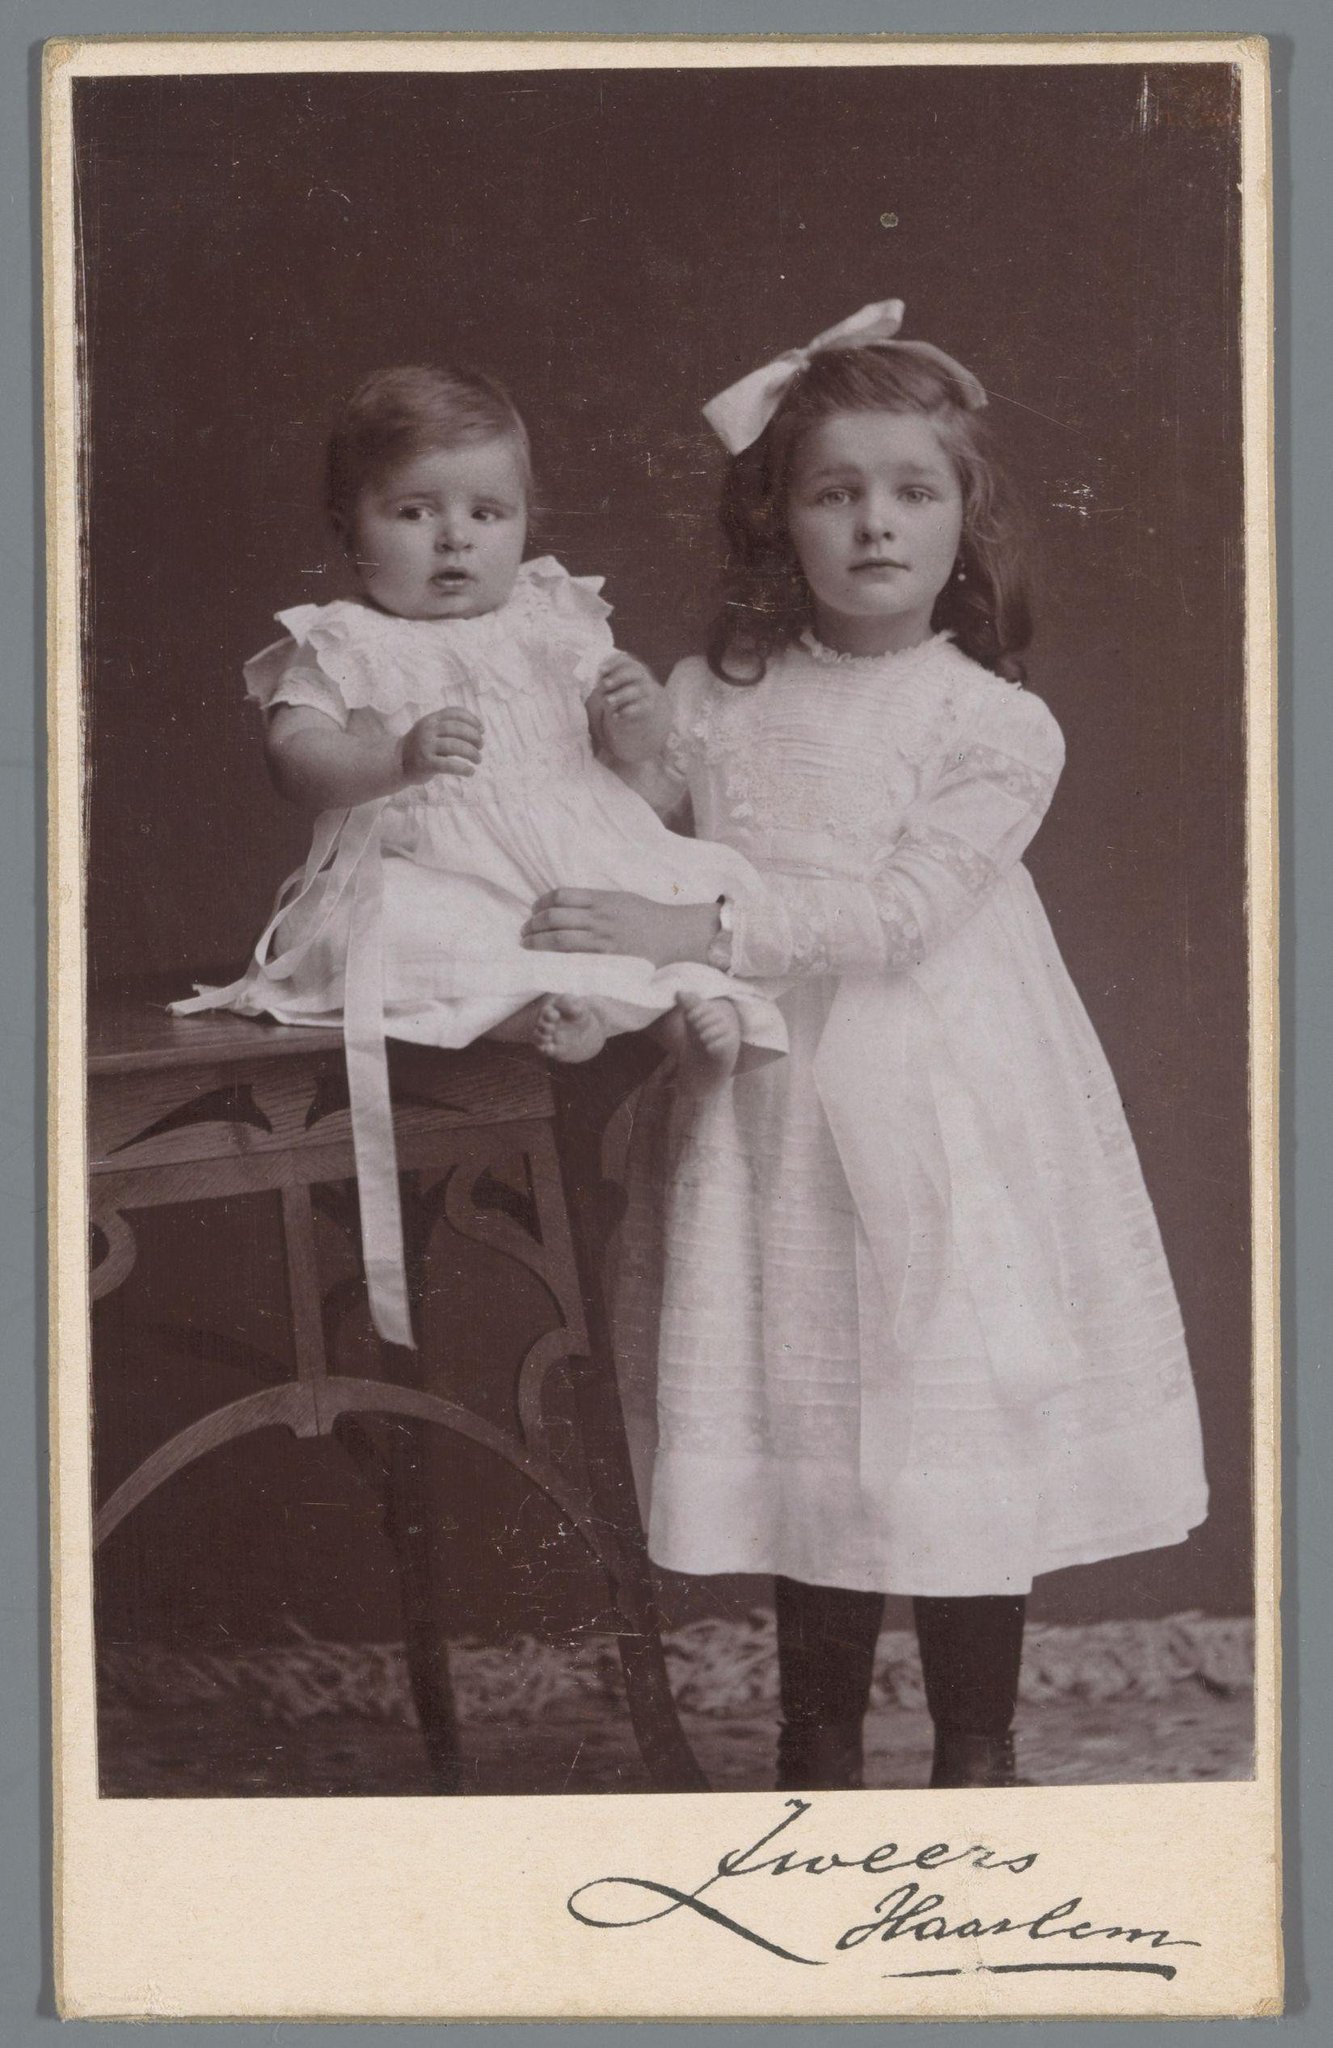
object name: photograph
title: Portret van een onbekend meisje en een baby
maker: berend zweers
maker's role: fotograaf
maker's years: 1872-1946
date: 1923-1934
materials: paper, cardboard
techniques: collodion silver print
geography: haarlem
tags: girl (child between toddler and youth), anonymous historical person portrayed, infant, baby ~ the ages of man, haarlem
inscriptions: inscription: ‘Zweers/ Haarlem’, inscription: ‘B. Zweers/ Groote Houtstraat 174/ Haarlem/ Telefoon 1669/ Onderscheidingen/ Amsterdam 1895/ Turijn 1902/ 's Gravenhage 1906/ Leeuwarden 1906/ Leiden 1907/ Harlingen 1908/ Zeist 1908/ 's Gravenhage 1908/ Amsterdam 1908/ Dresden 1909’